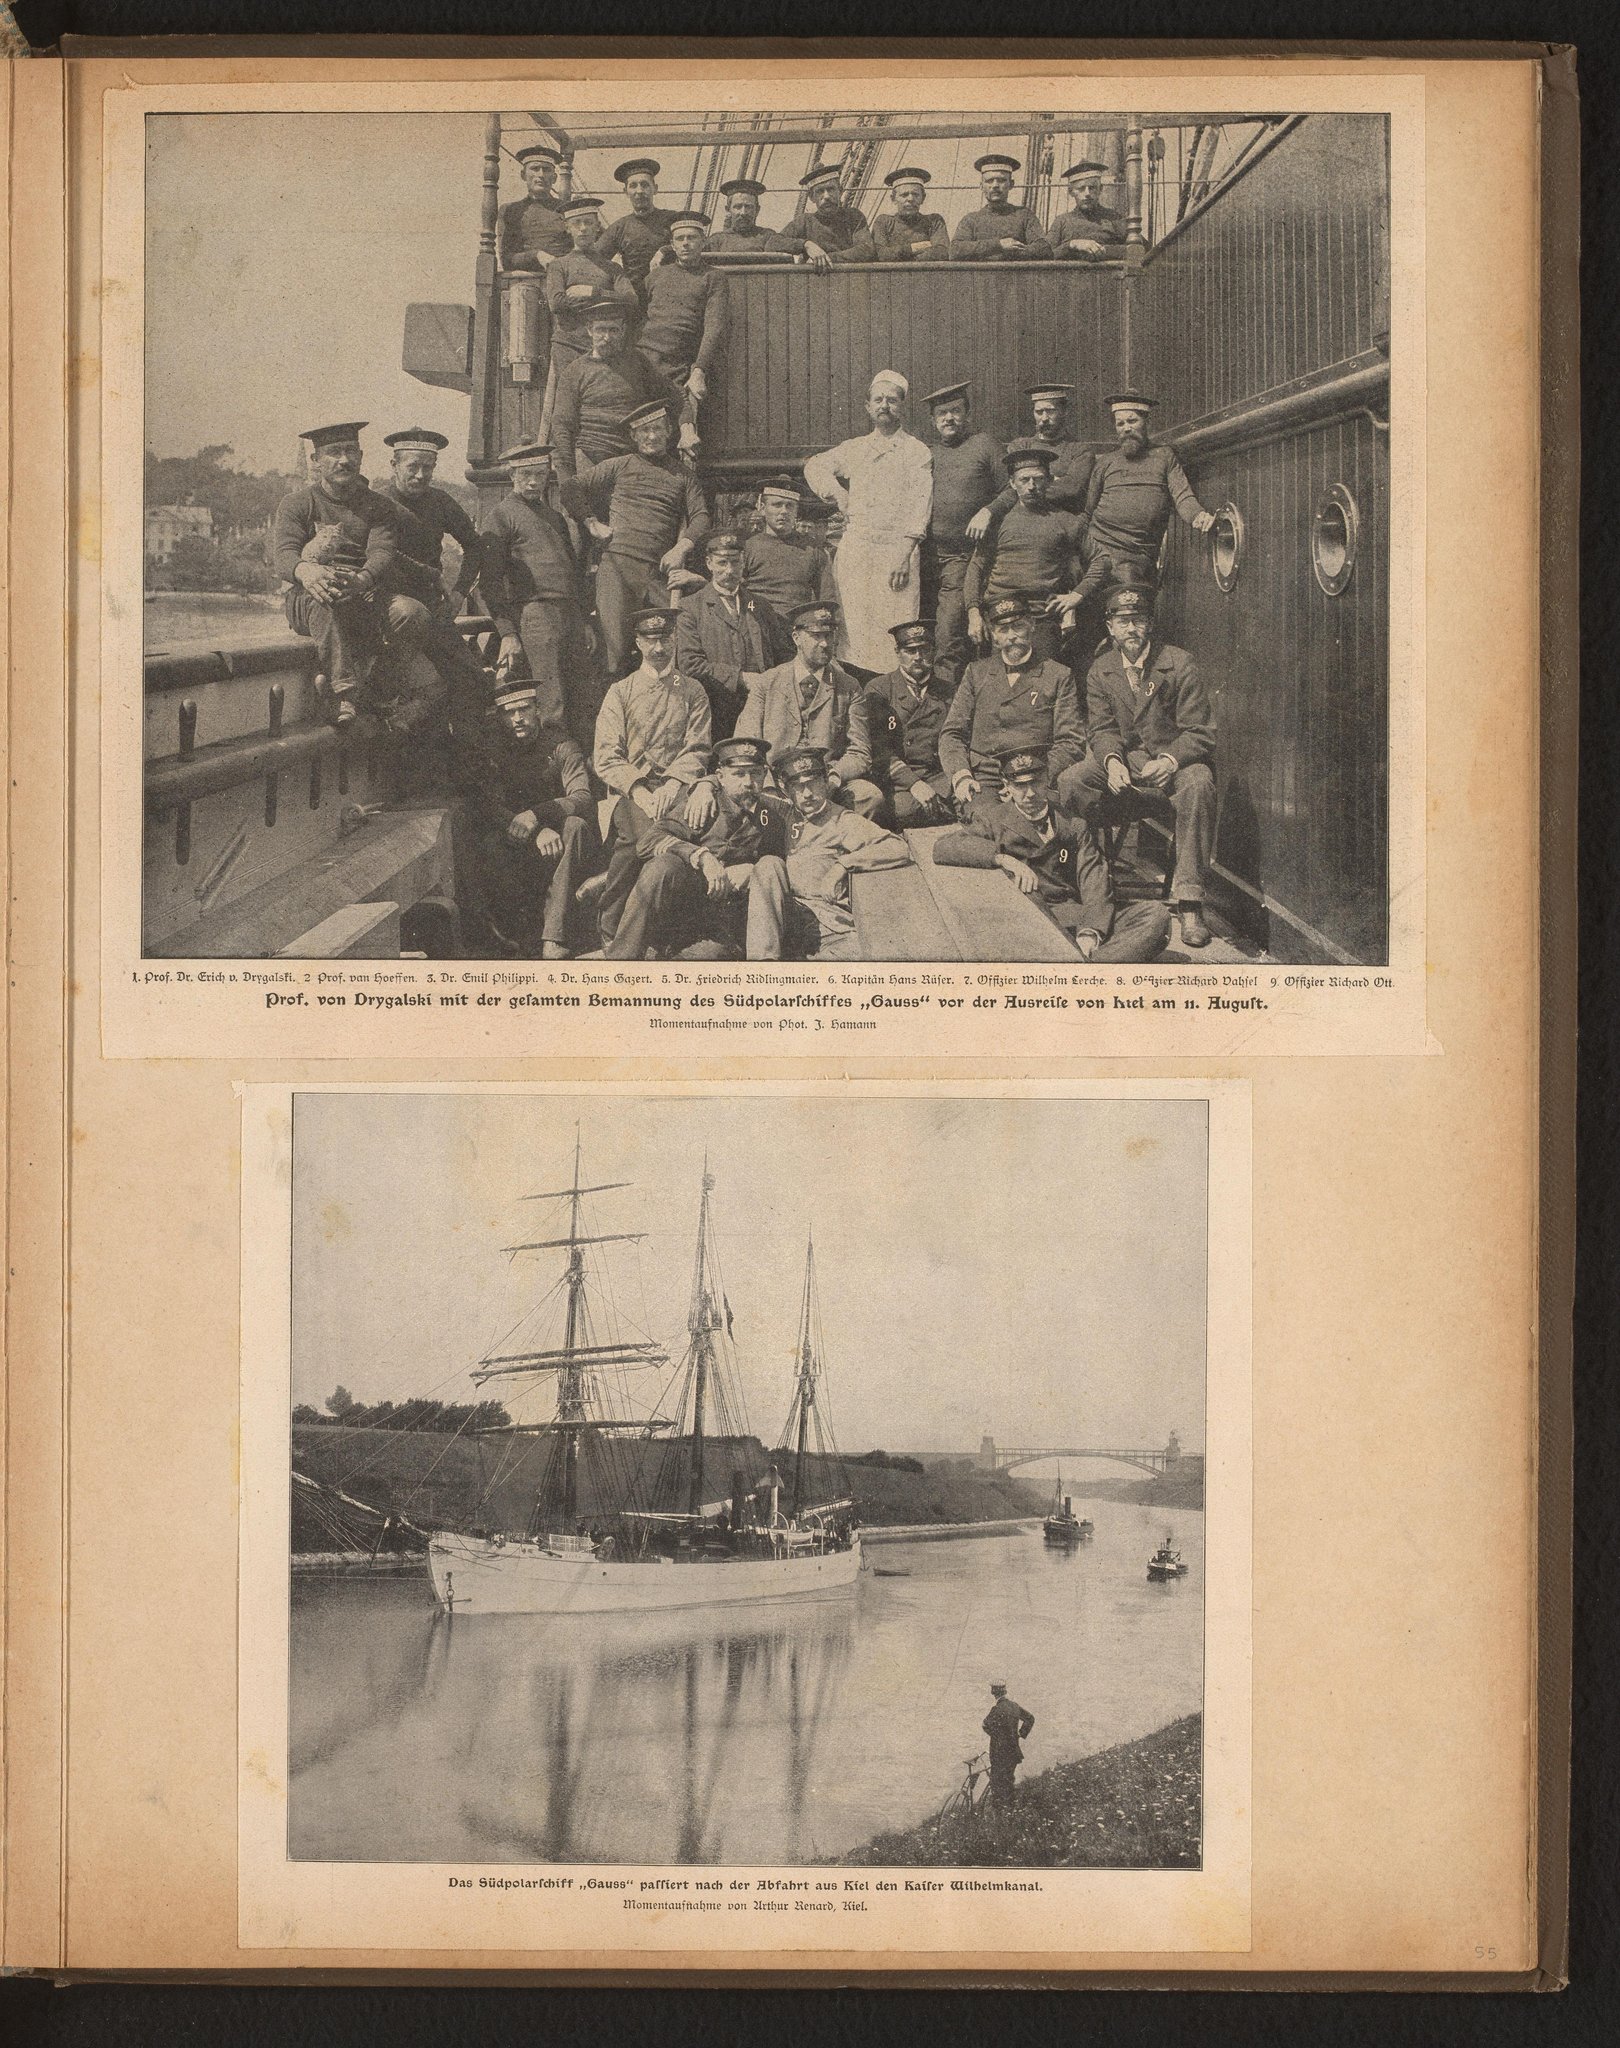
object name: photomechanical print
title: Groepsportret van de bemanning en het schip Gauss van een poolexpeditie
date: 1901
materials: paper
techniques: autotype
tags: sailing-ship, sailing-boat, exploration, expedition, voyage of discovery, anonymous historical persons portrayed in a group, in a group-portrait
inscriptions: inscription: ‘1. Prof. Dr. Erich v. Drygalski (...) Phot. J. Hamann.’, inscription: ‘Das Südpolarschiff "Gauss" (...) Arthur Renard, Kiel.’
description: Deze fotomechanische afdrukken maken deel uit van een album.